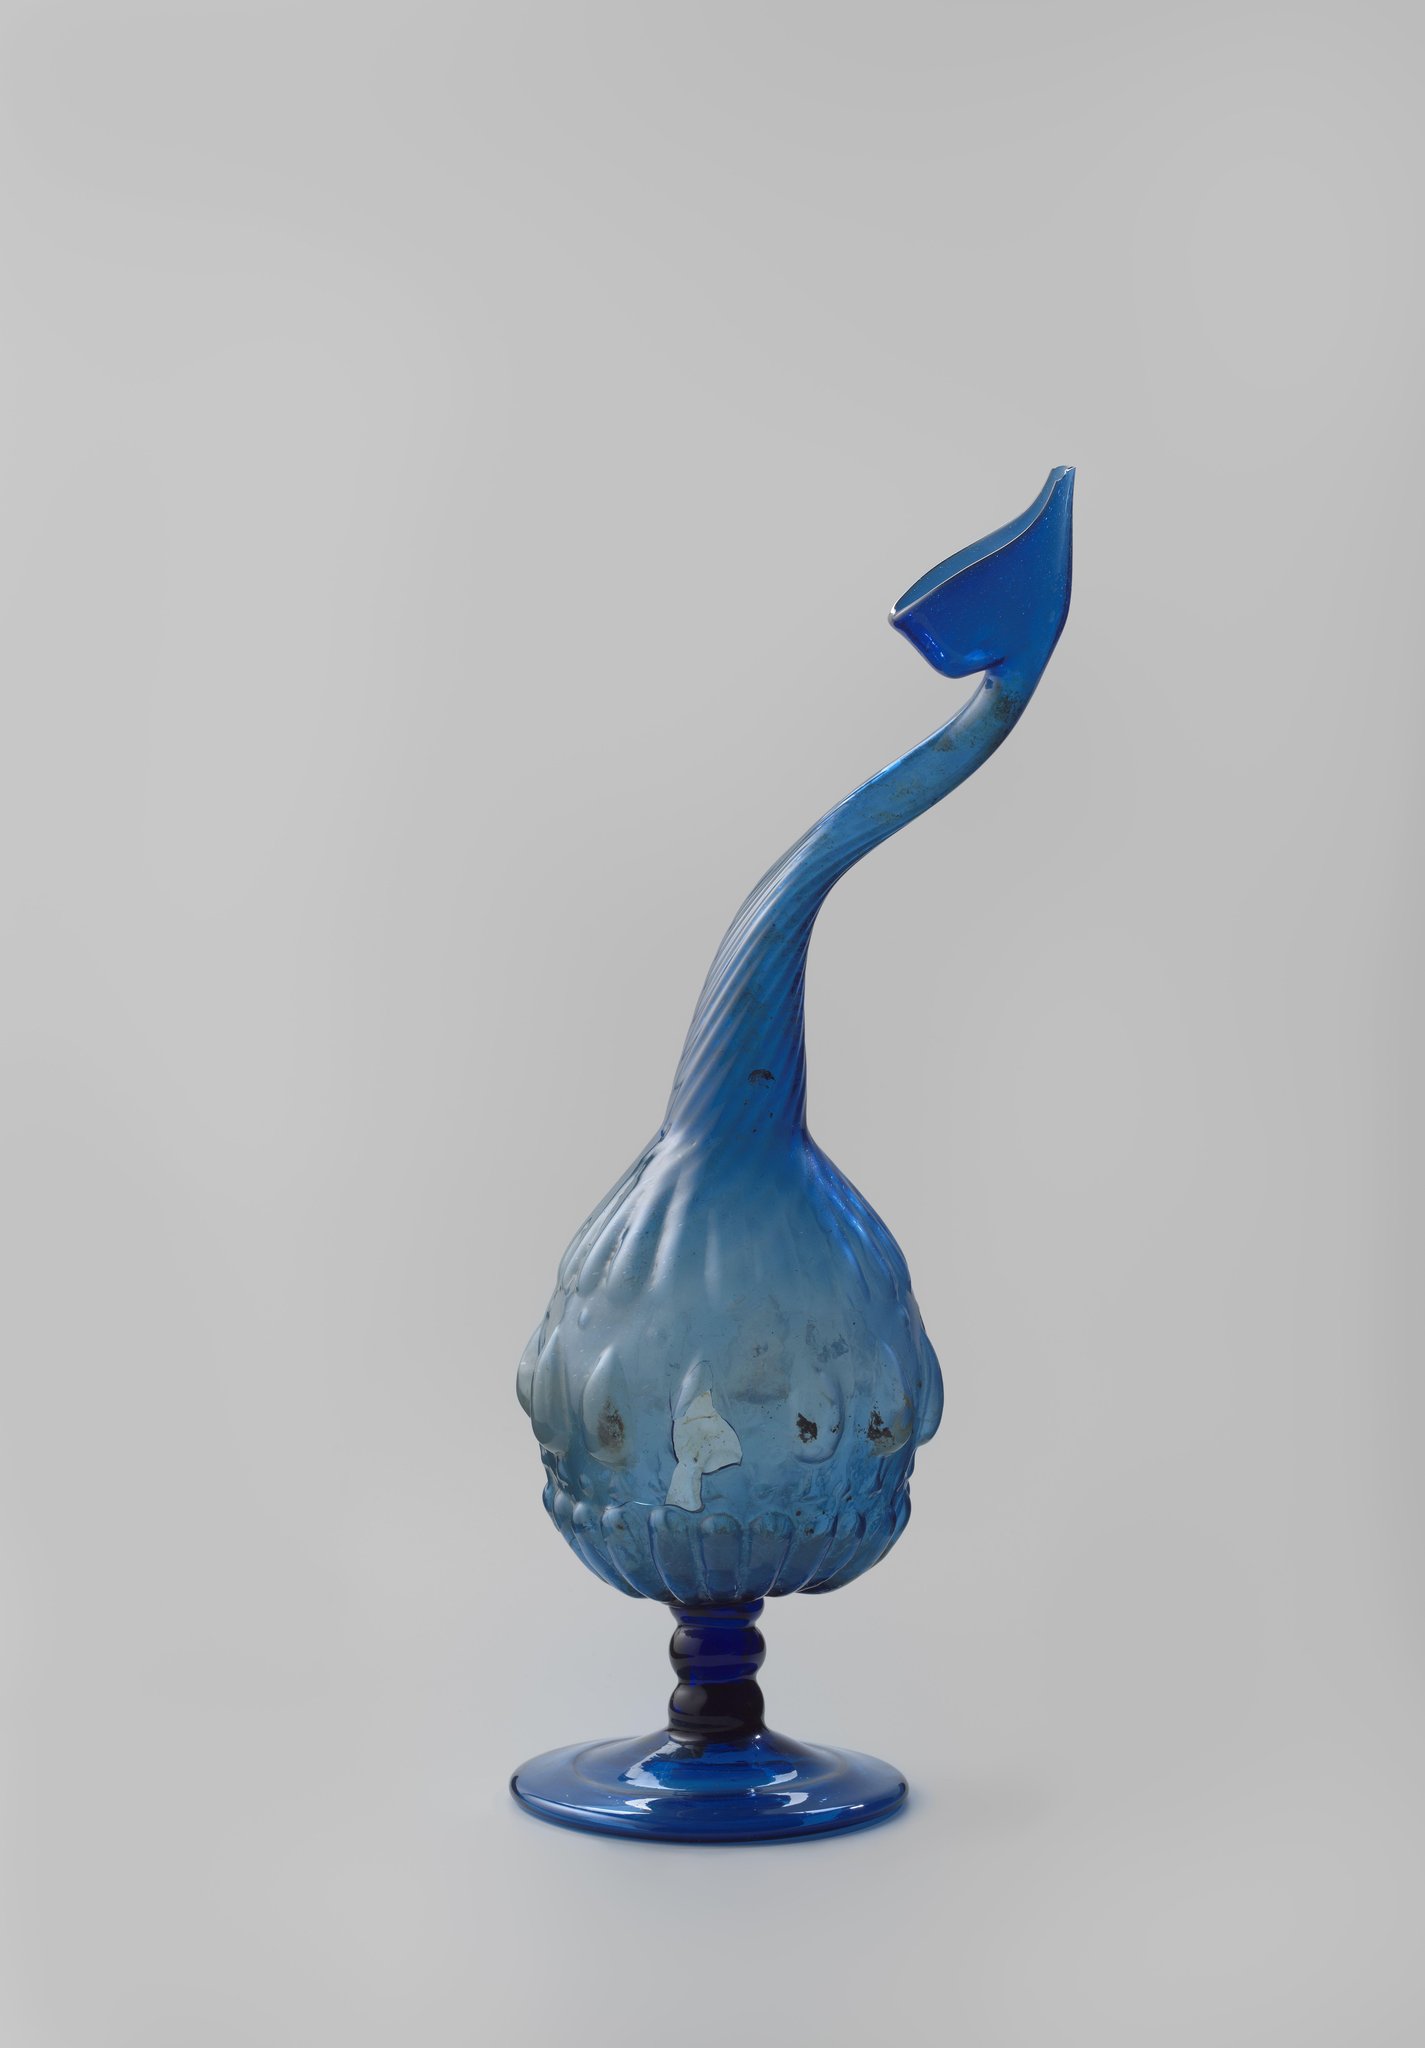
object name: sprinkler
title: Sprinkler van blauw glas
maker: Anonymous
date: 1700-1900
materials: glass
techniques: glassblowing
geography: iran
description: Sprinkler met platte voet met holle, omgeslagen rand. Stam opgebouwd uit drie holle nodi. Peervormig lichaam, in de vorm geblazen met knorren en ribben, overgaande in een geribde, getordeerde en gebogen hals, die uitloopt in een wijde mond met een smal tuitje.